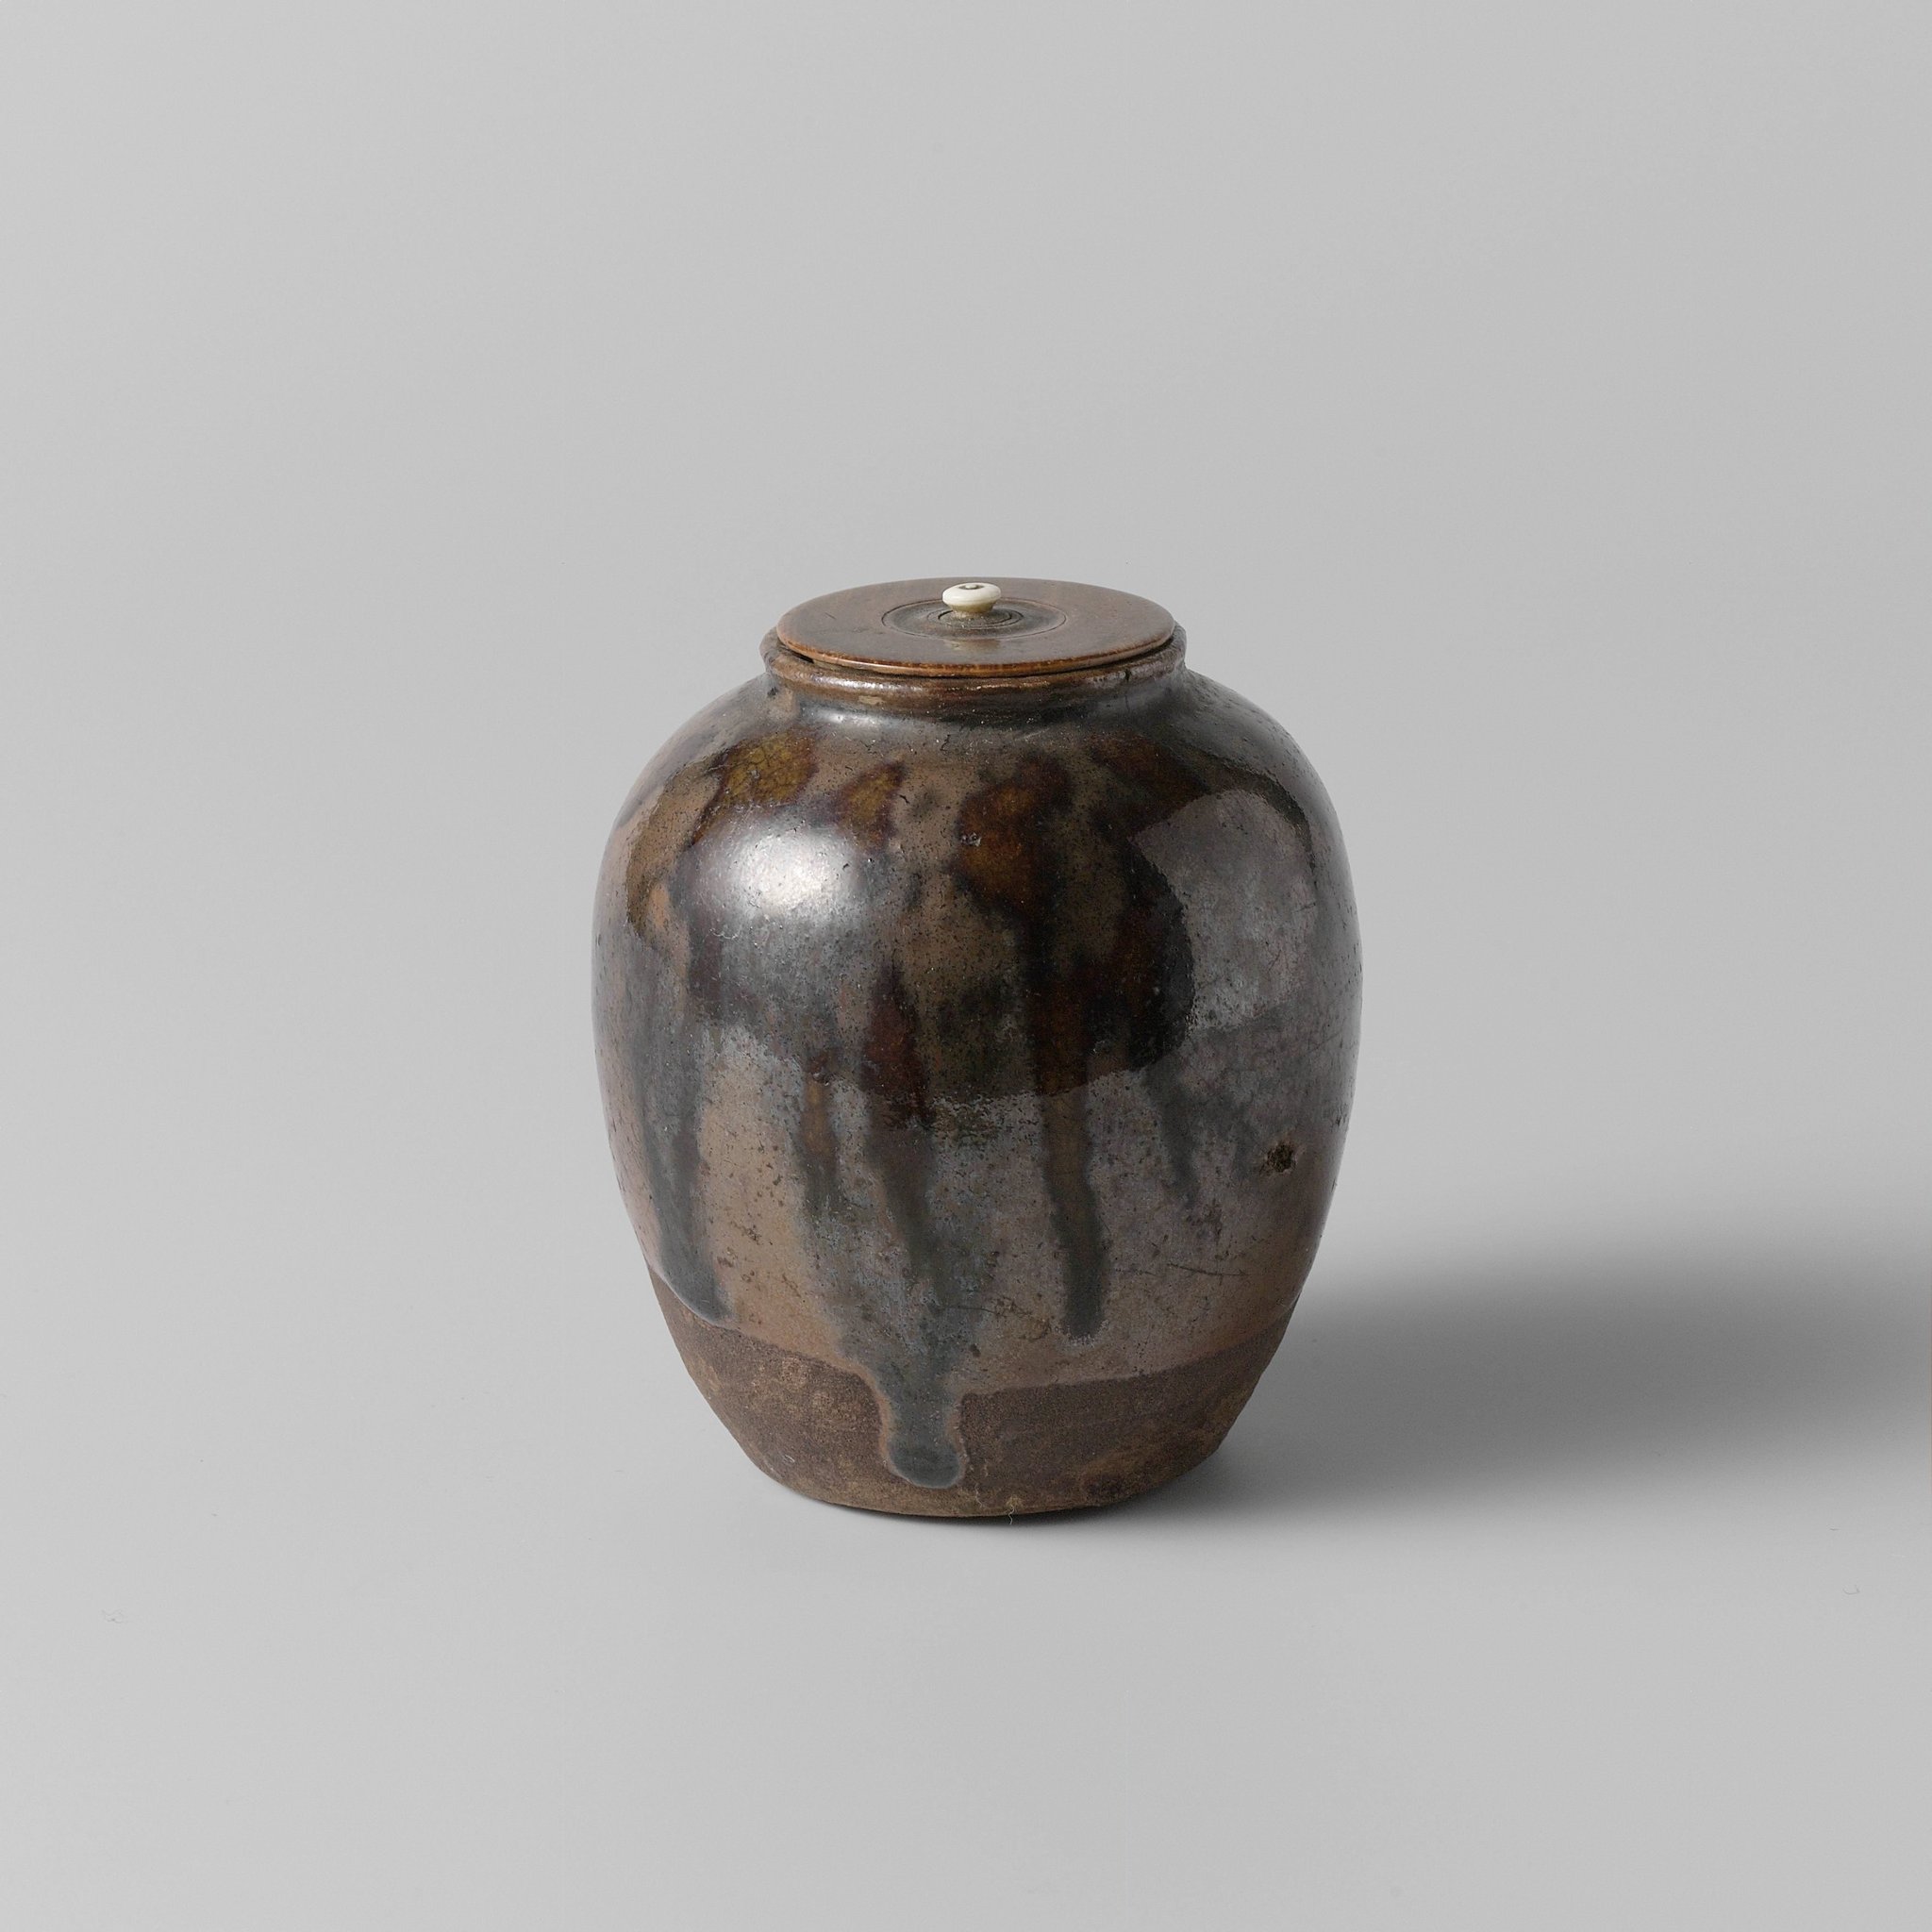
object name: chaire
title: Tea caddy with a goldenbrown glaze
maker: Anonymous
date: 1700-1800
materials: glaze, ivory, stoneware, wood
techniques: firing, turning, vitrification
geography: japan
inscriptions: label: ‘Seto, Shunkei-yaki’, label: ‘Seto/ 18e?’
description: Stoftheebus of chaire van steengoed met een houten en ivoren deksel, gedeeltelijk bedekt met een goudbruin glazuur. De onderzijde van de bus is ongeglazuurd. Twee oude labels aan de binnenzijde met 'Seto/ 18e?' en 'Seto, Shunkei-yaki'. Shunkei-yaki.